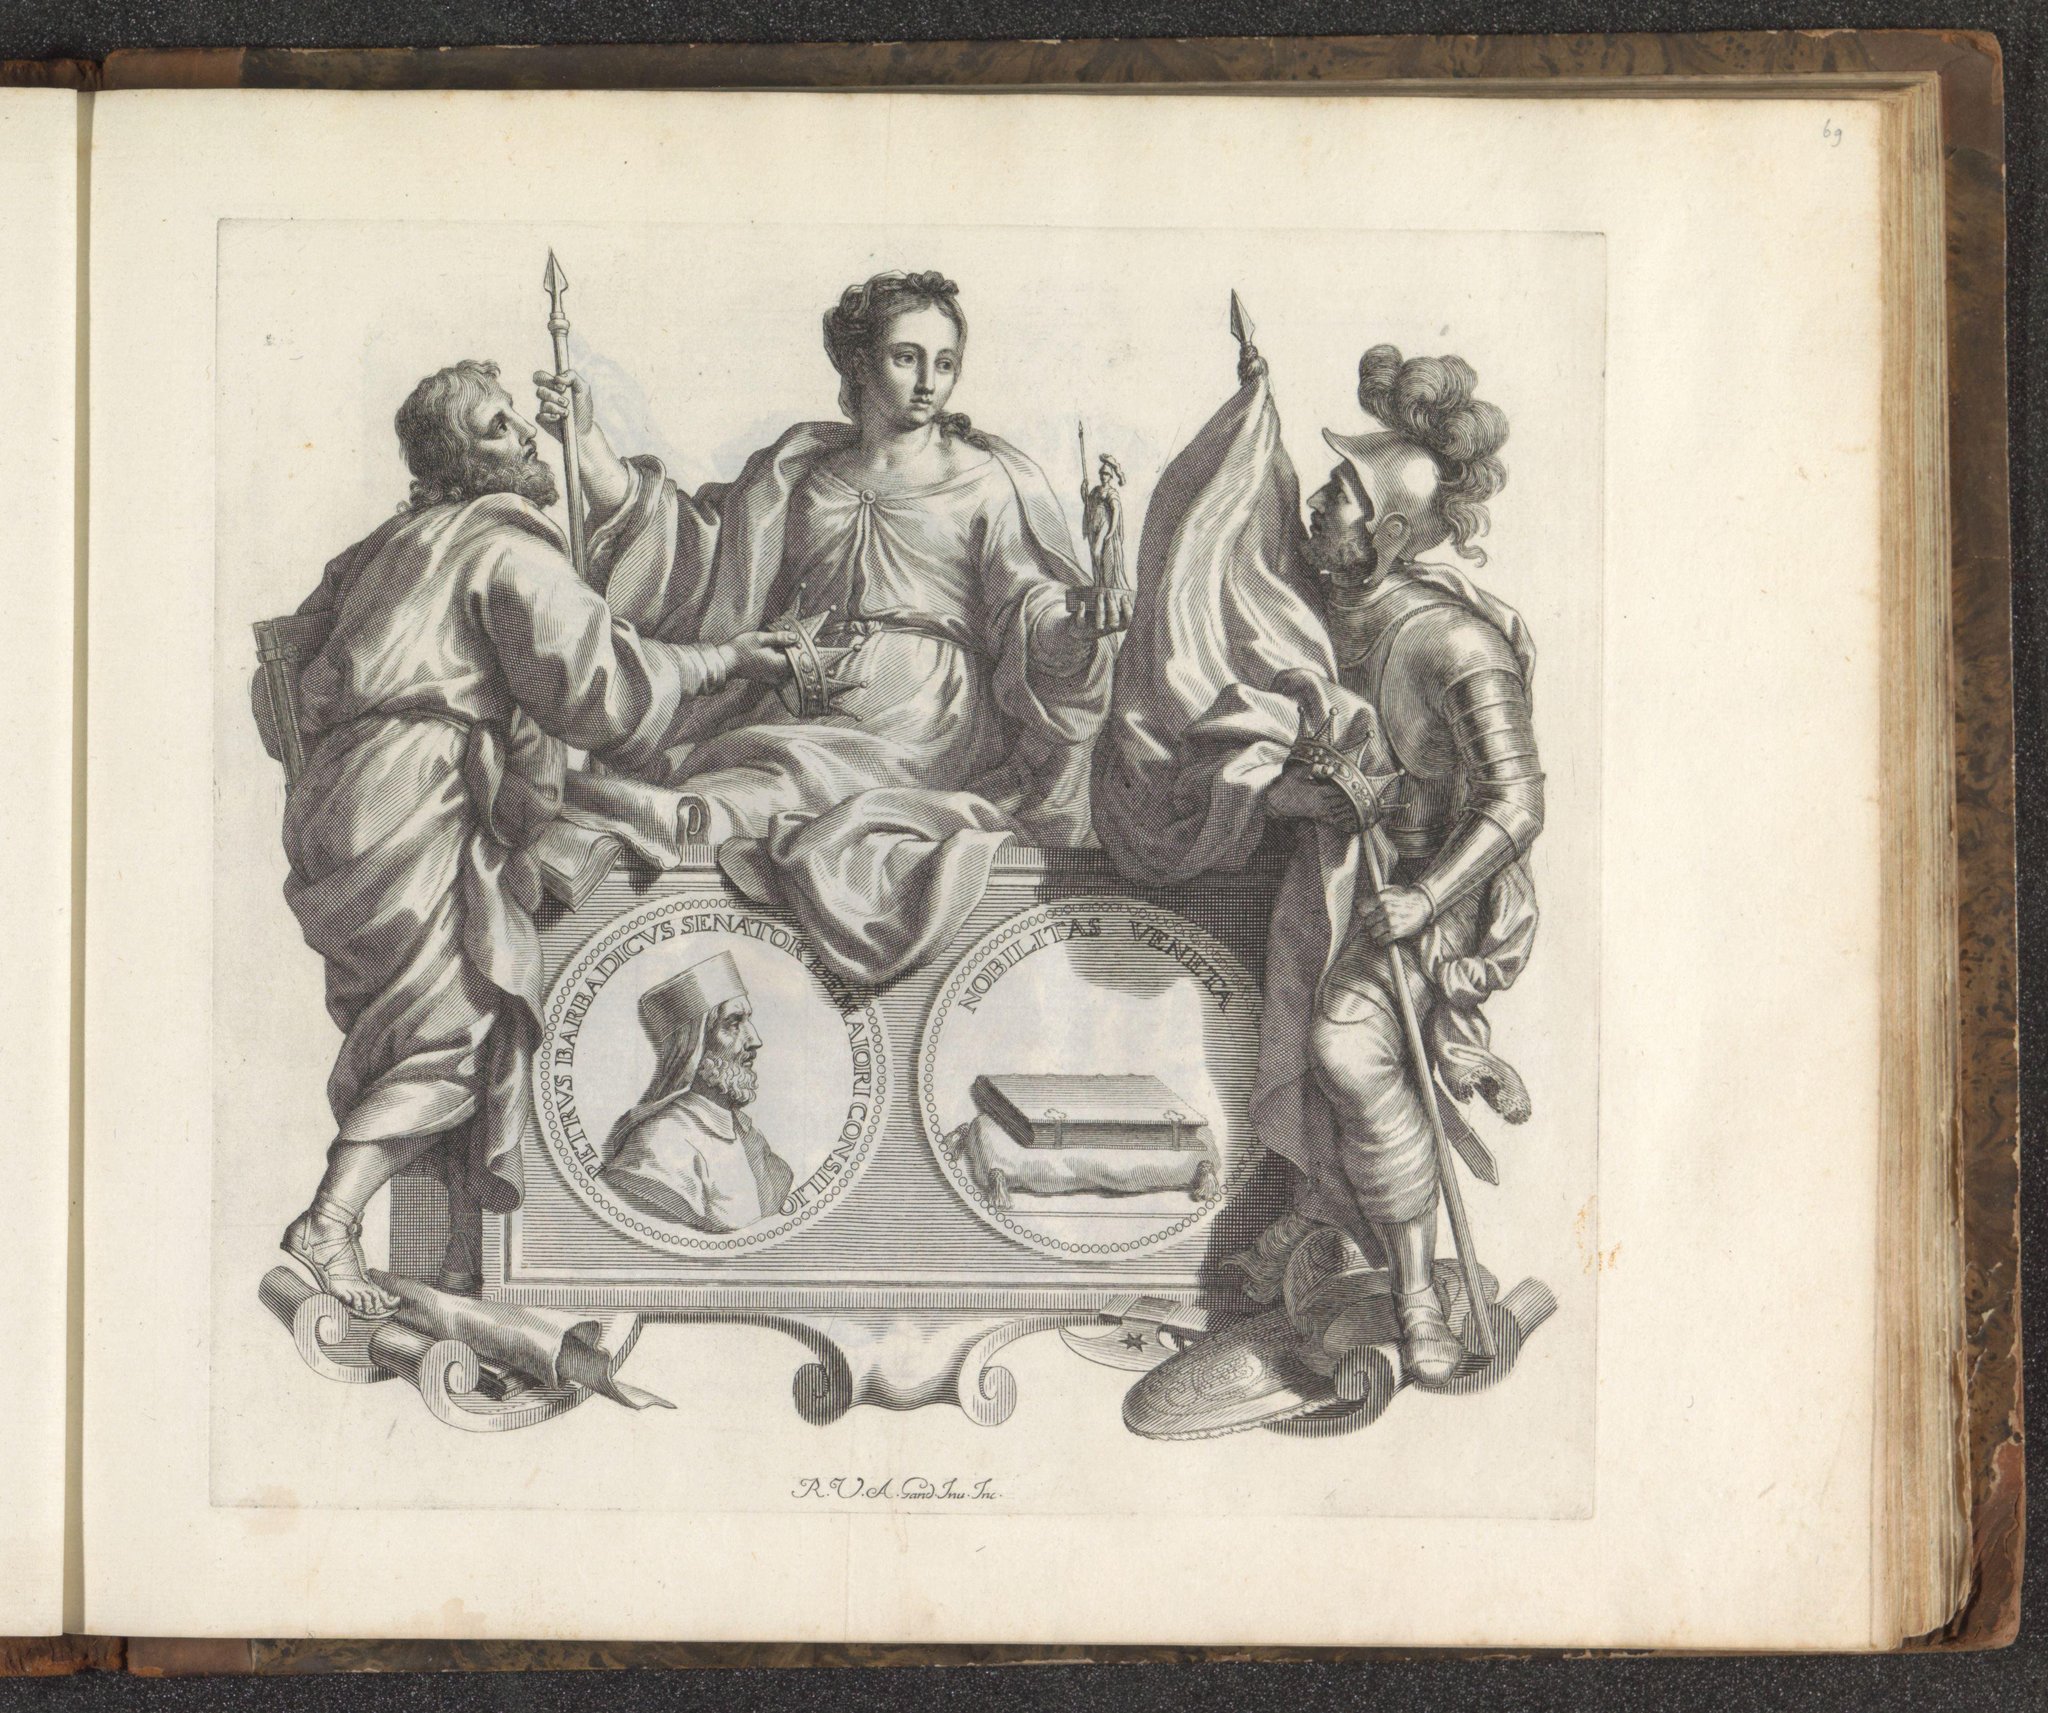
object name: album leaf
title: Numismata virorum illustrium ex Barbadica gente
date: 1673-1743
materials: paper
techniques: engraving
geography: rome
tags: nobility; 'nobiltà' (ripa), standard-bearer, flag-bearer, medal (considered as a piece of sculpture, regardless of its specific function), book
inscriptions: collector's mark: Lugt 2228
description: Voetstuk in de vorm van een cartouche. Daarop een medaillon met op de voorkant het portret van Pietro Barbarigo. Op de achterkant een gesloten boek op een kussen en de tekst: Nobilitas Veneta. Rondom het voetstuk bieden Bestuur en Krijgsmacht hun kroon aan de Edelheid aan. Edelheid heeft een lans en een beeld van Minerva in haar handen. De prent maakt deel uit van een album.